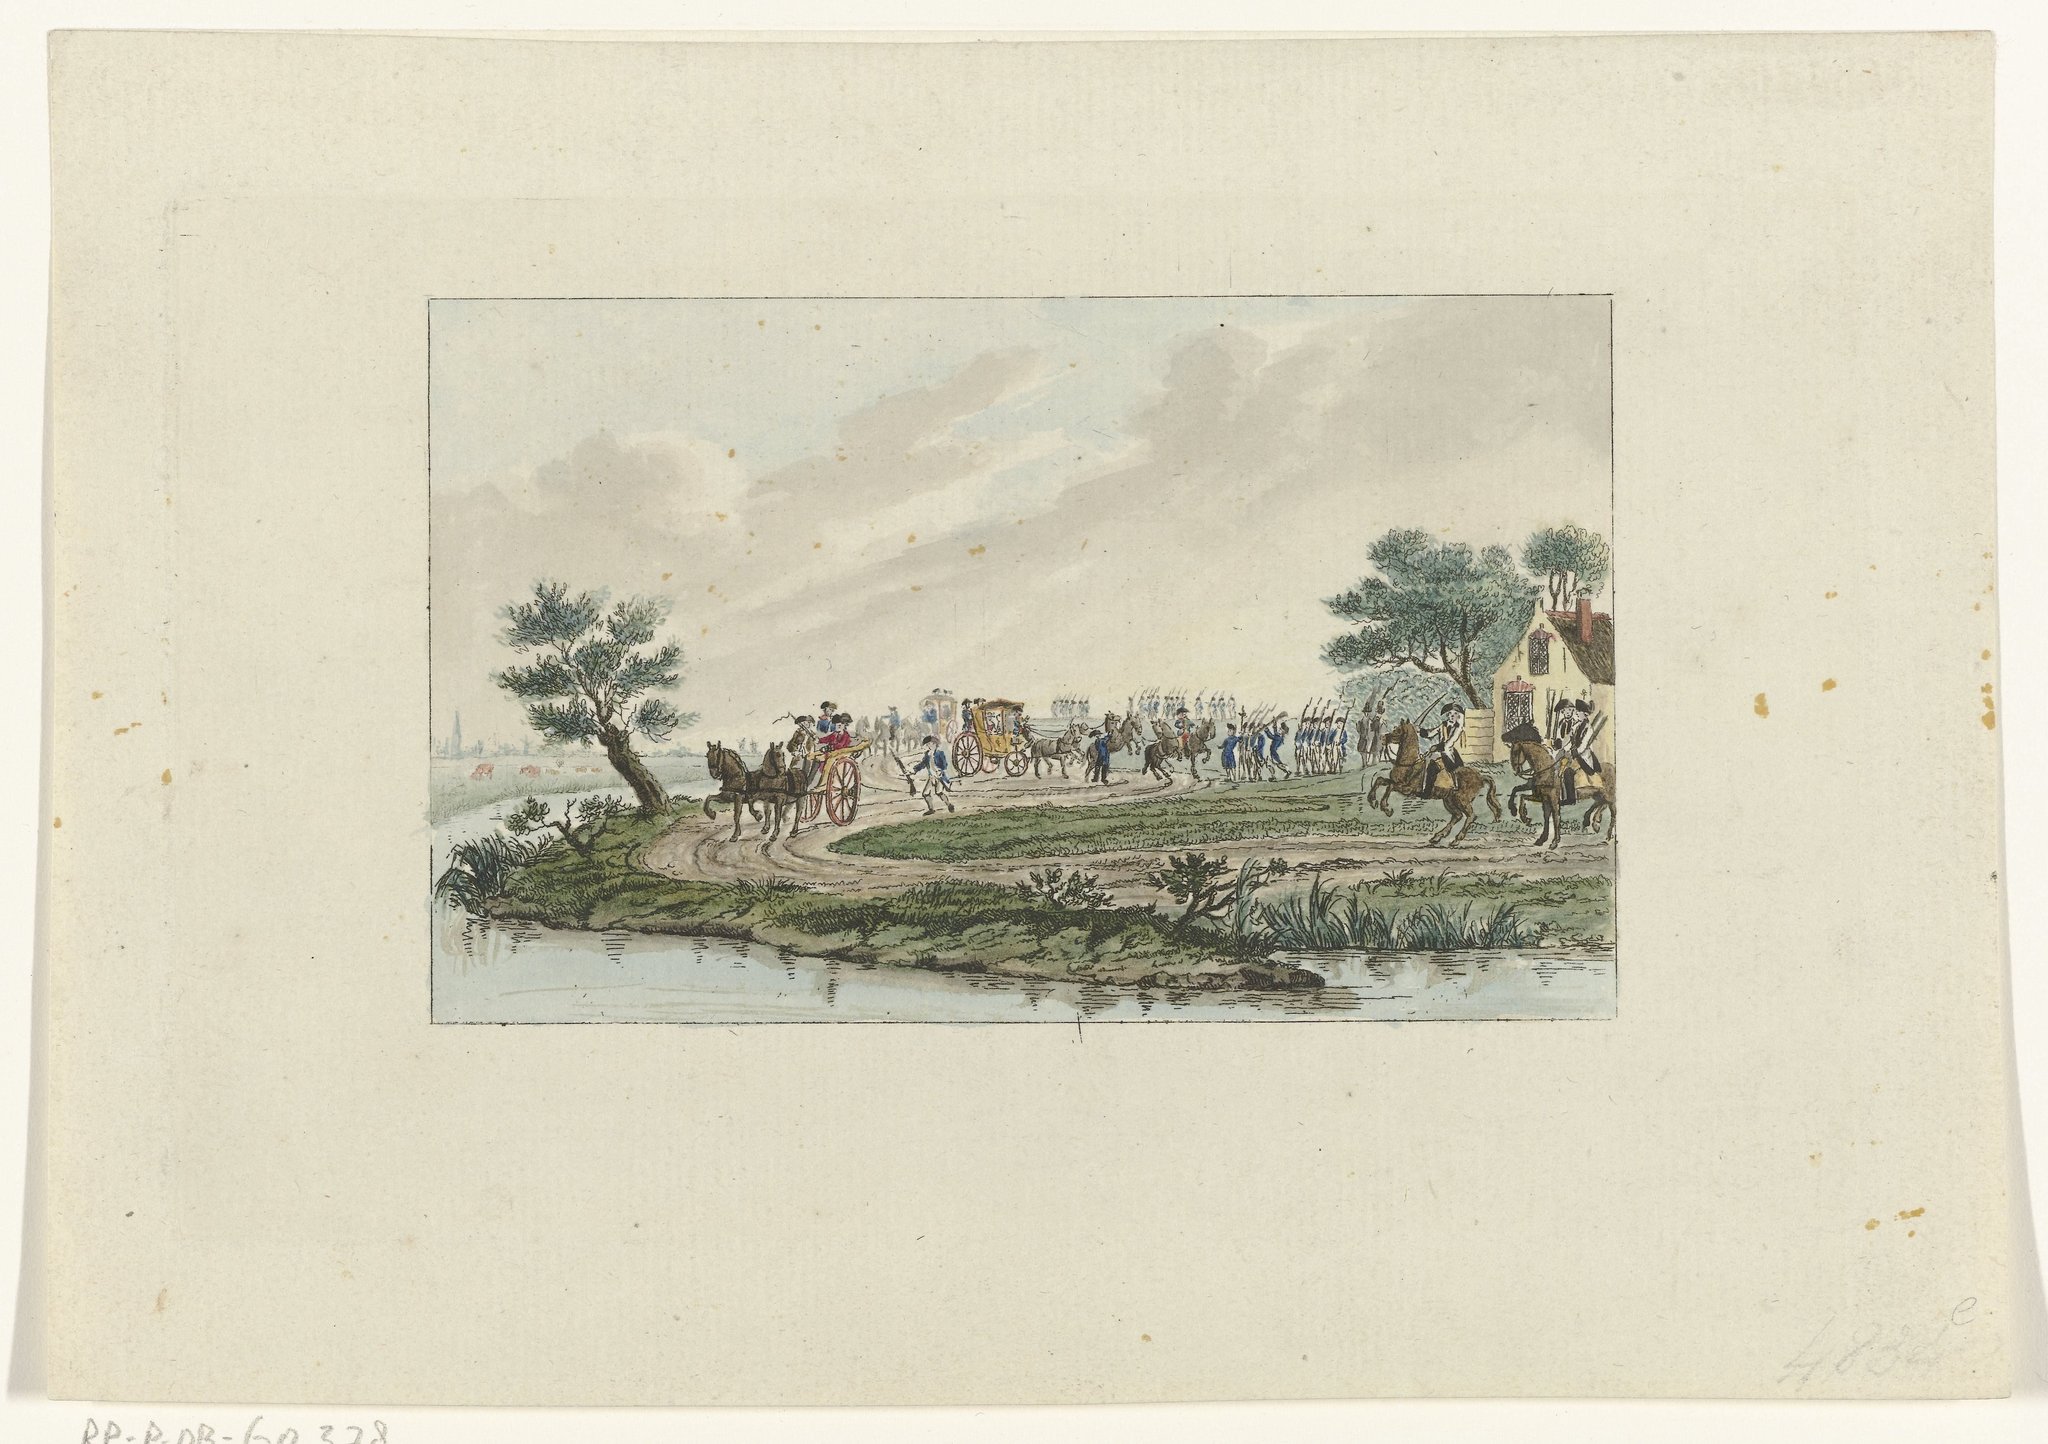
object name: print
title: Aanhouding van de prinses bij Goejanverwellesluis, 1787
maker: mathias de sallieth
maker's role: print maker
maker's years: 1749-1791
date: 1787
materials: paper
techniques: etching, hand coloring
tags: berlin, draughtsman, wilhelmina of prussia (princess of orange), arrest (of criminal)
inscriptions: collector's mark: Lugt 2228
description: Staat met de letter gebruikt als illustratie in: De Haagsche princelyke en koninglyke almanach, voor het schrikkeljaar 1788. Johannes François Jacobs d'Agé: 's-Gravenhage, 1788.